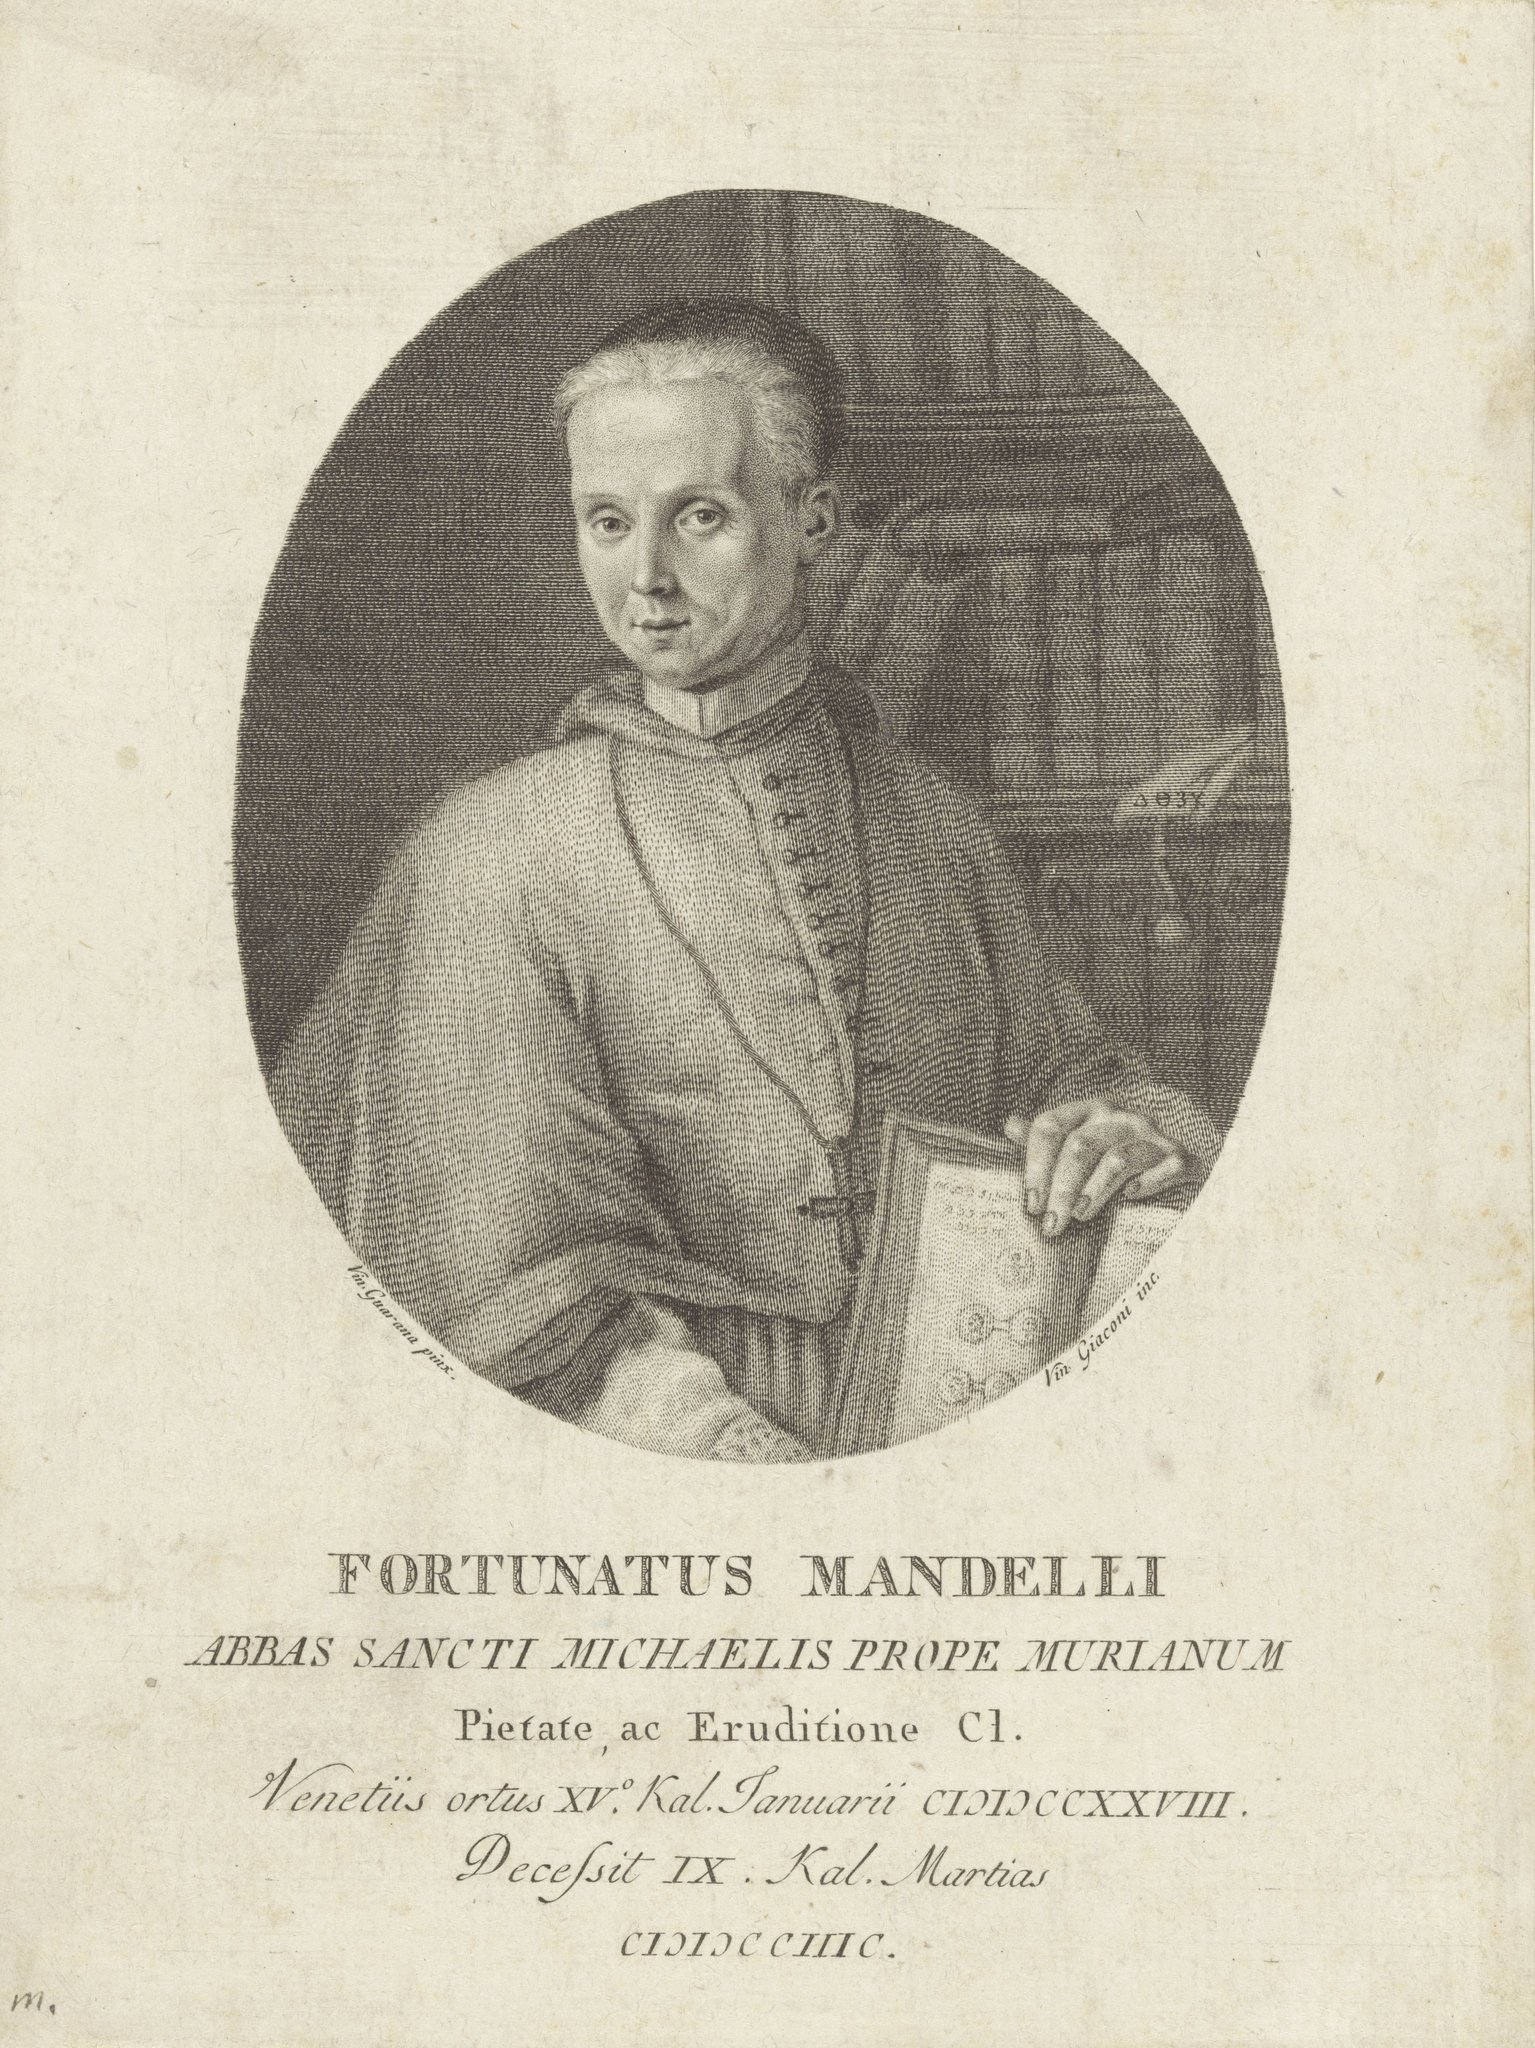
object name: print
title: Portret van geestelijke Fortunatus Mandelli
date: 1797-1829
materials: paper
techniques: etching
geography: venice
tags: clergyman, historical persons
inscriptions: inscription: ‘m.’, collector's mark: Lugt 2228